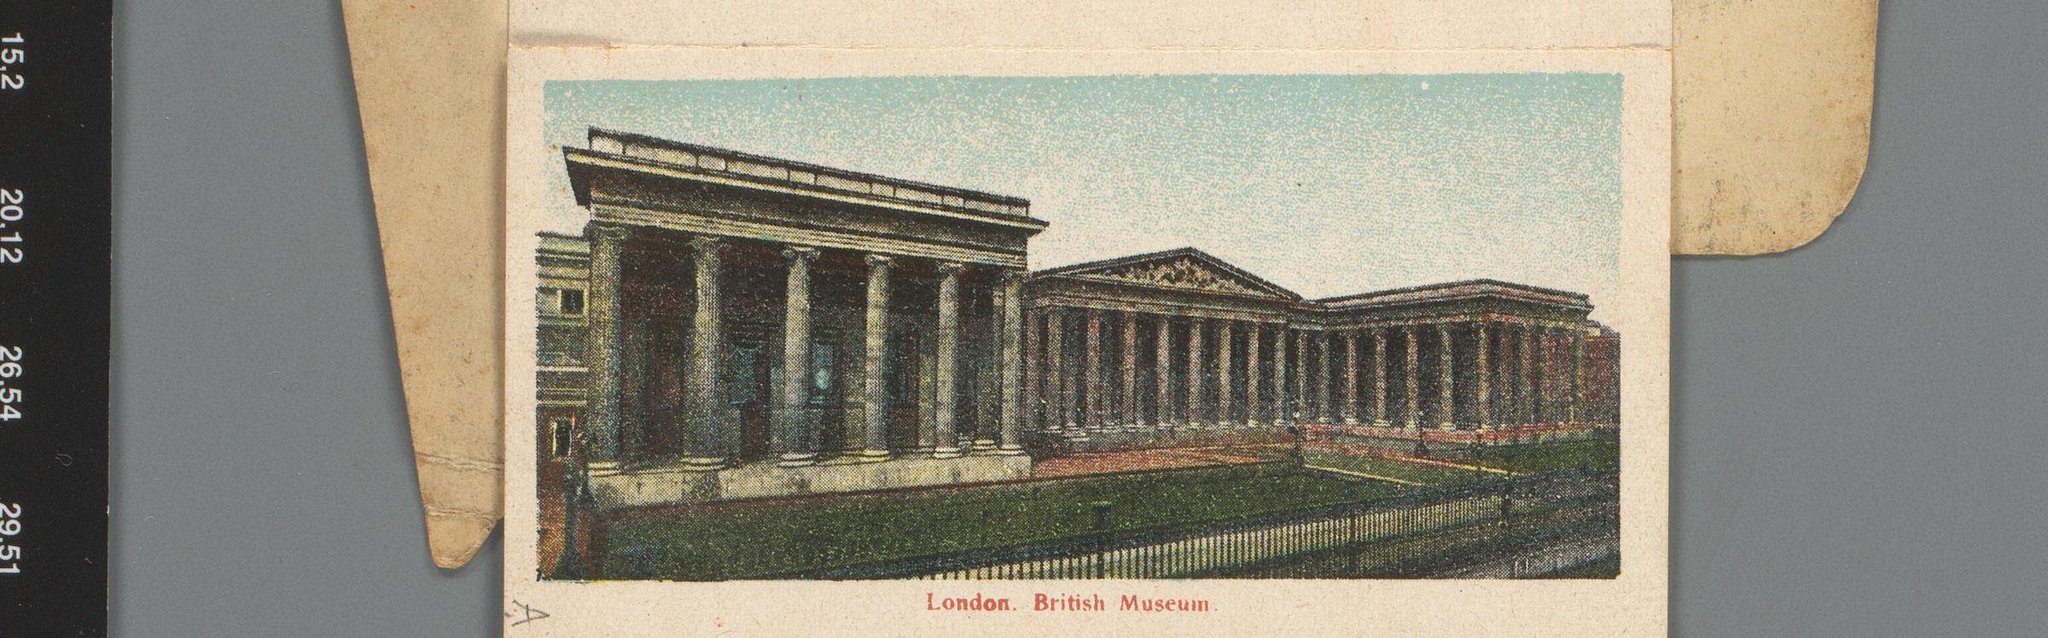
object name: photomechanical print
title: Exterieur van het British Museum, Londen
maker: Anonymous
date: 1888-1914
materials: paper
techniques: autotype, chromophotolithography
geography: london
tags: permanent exhibition, museum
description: Deze prent maakt deel uit van een album.